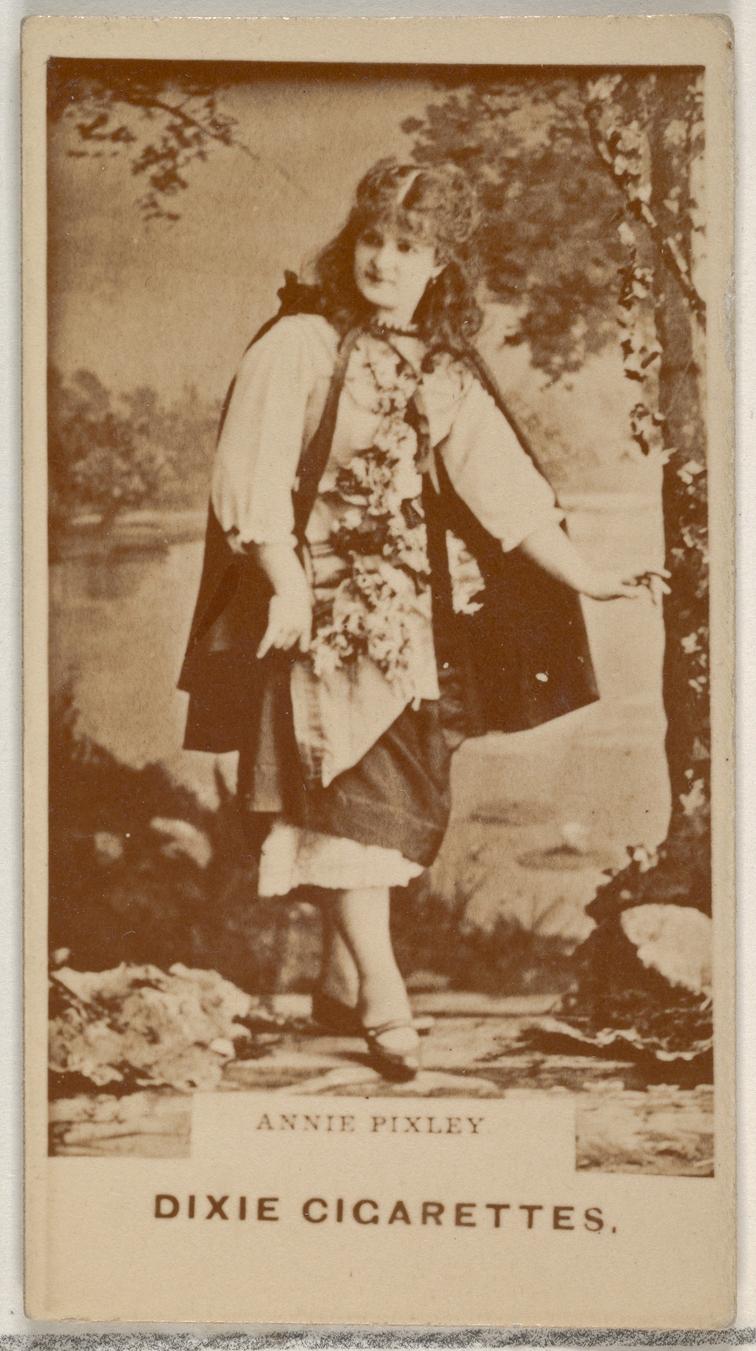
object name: photograph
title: Annie Pixley, from the Actors and Actresses series (N45, Type 7) for Dixie Cigarettes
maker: allen & ginter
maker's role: publisher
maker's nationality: american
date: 1888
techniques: albumen silver print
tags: portraits,women,actresses